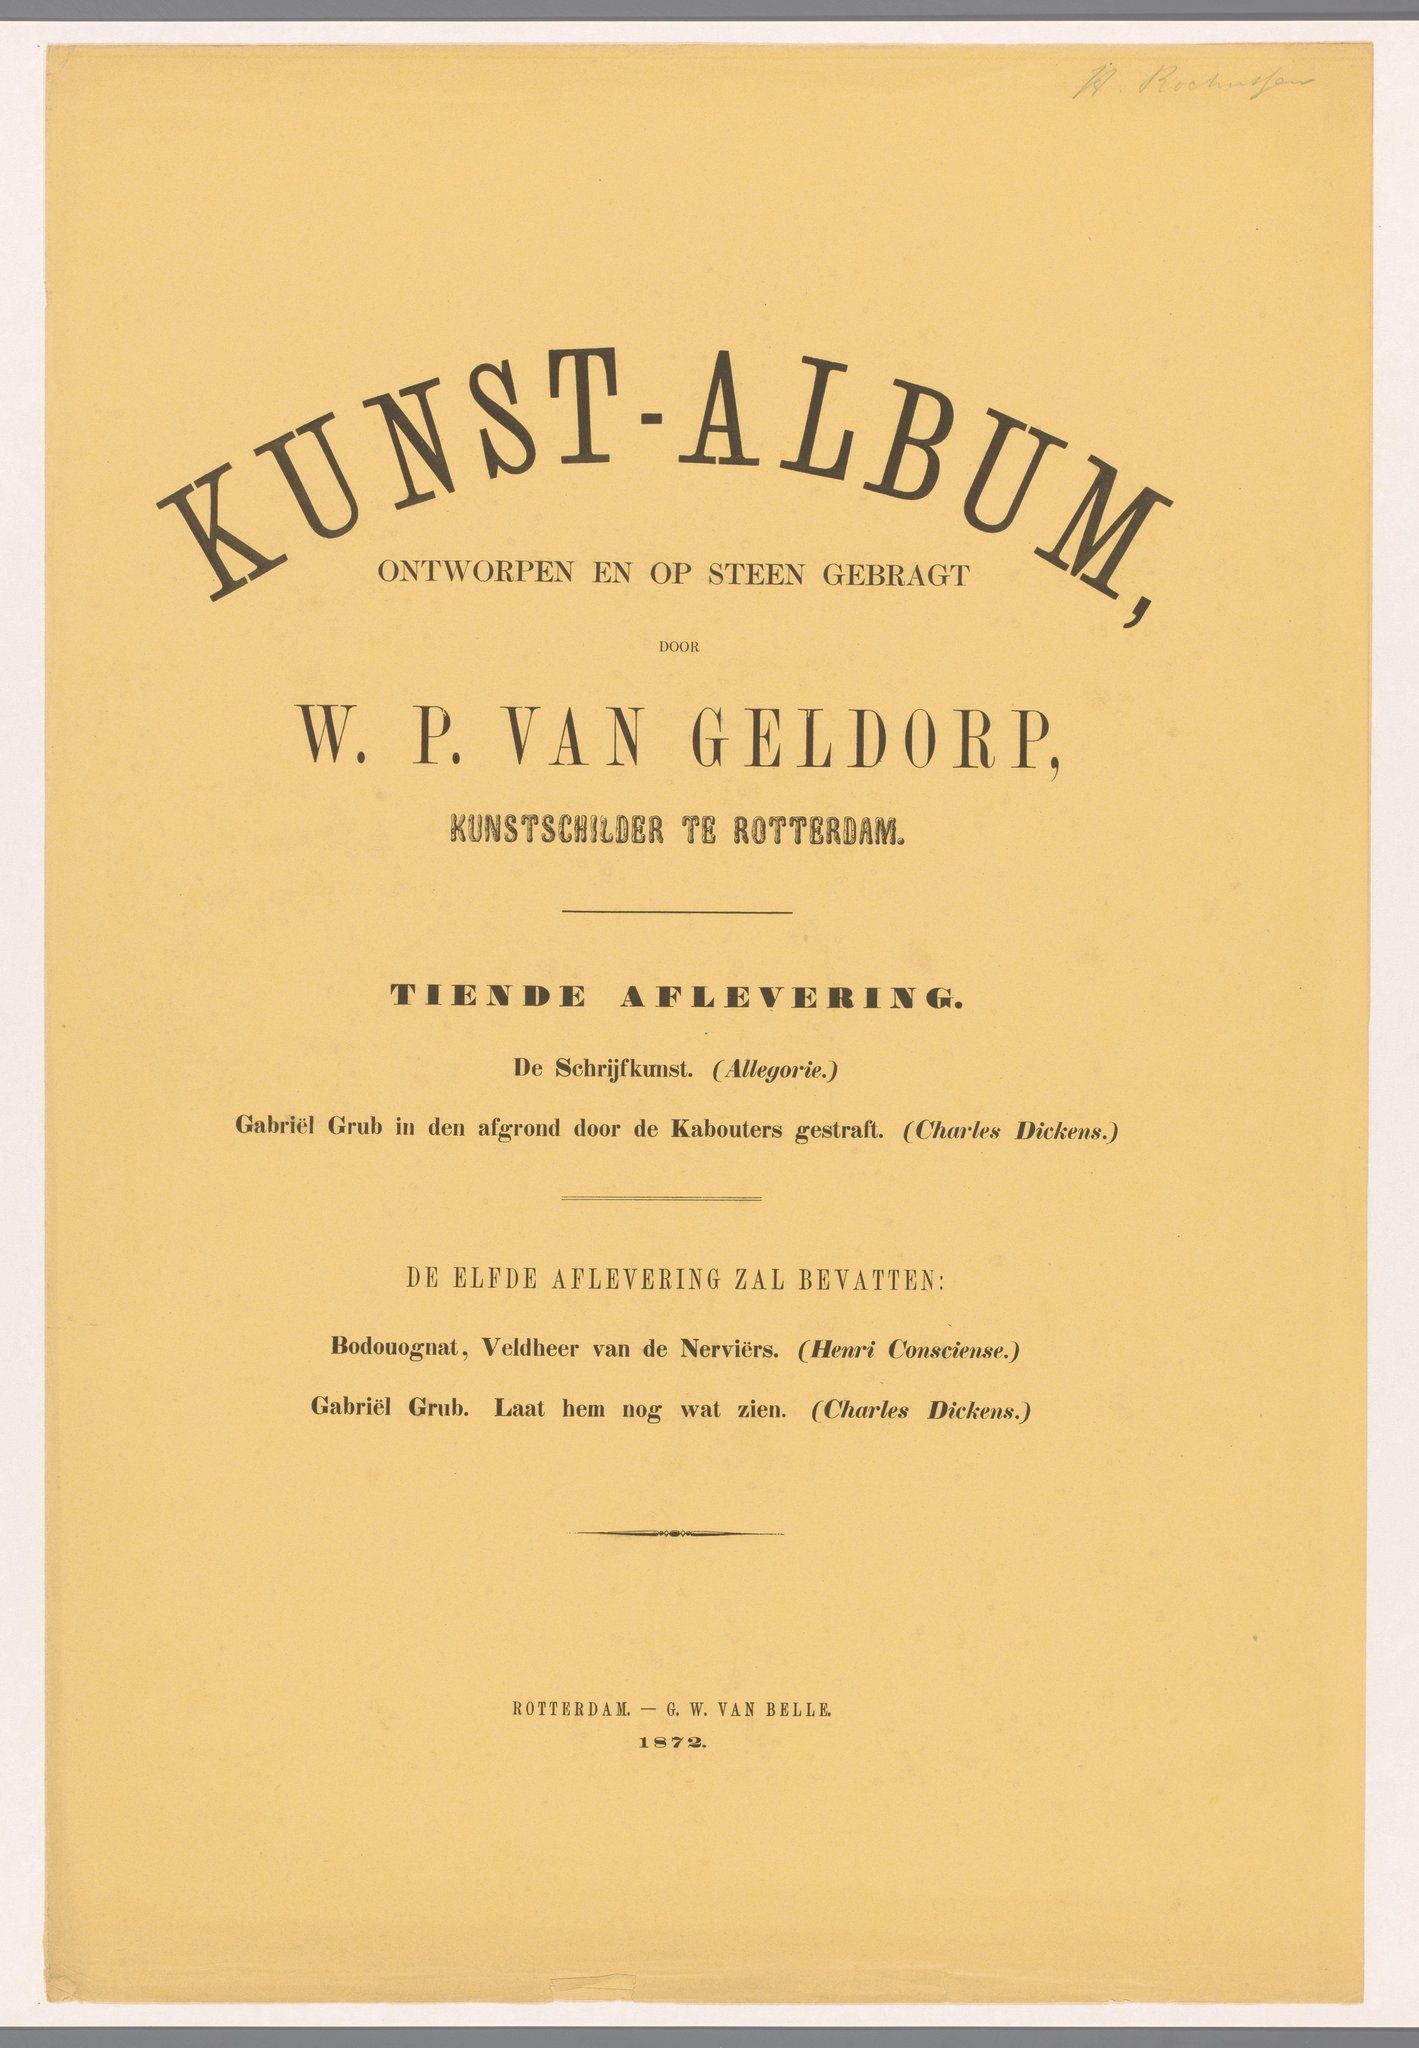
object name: print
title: Omslag voor Kunst-Album door W. P. van Geldorp tiende aflevering 1872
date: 1872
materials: paper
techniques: lithograph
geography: rotterdam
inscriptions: date